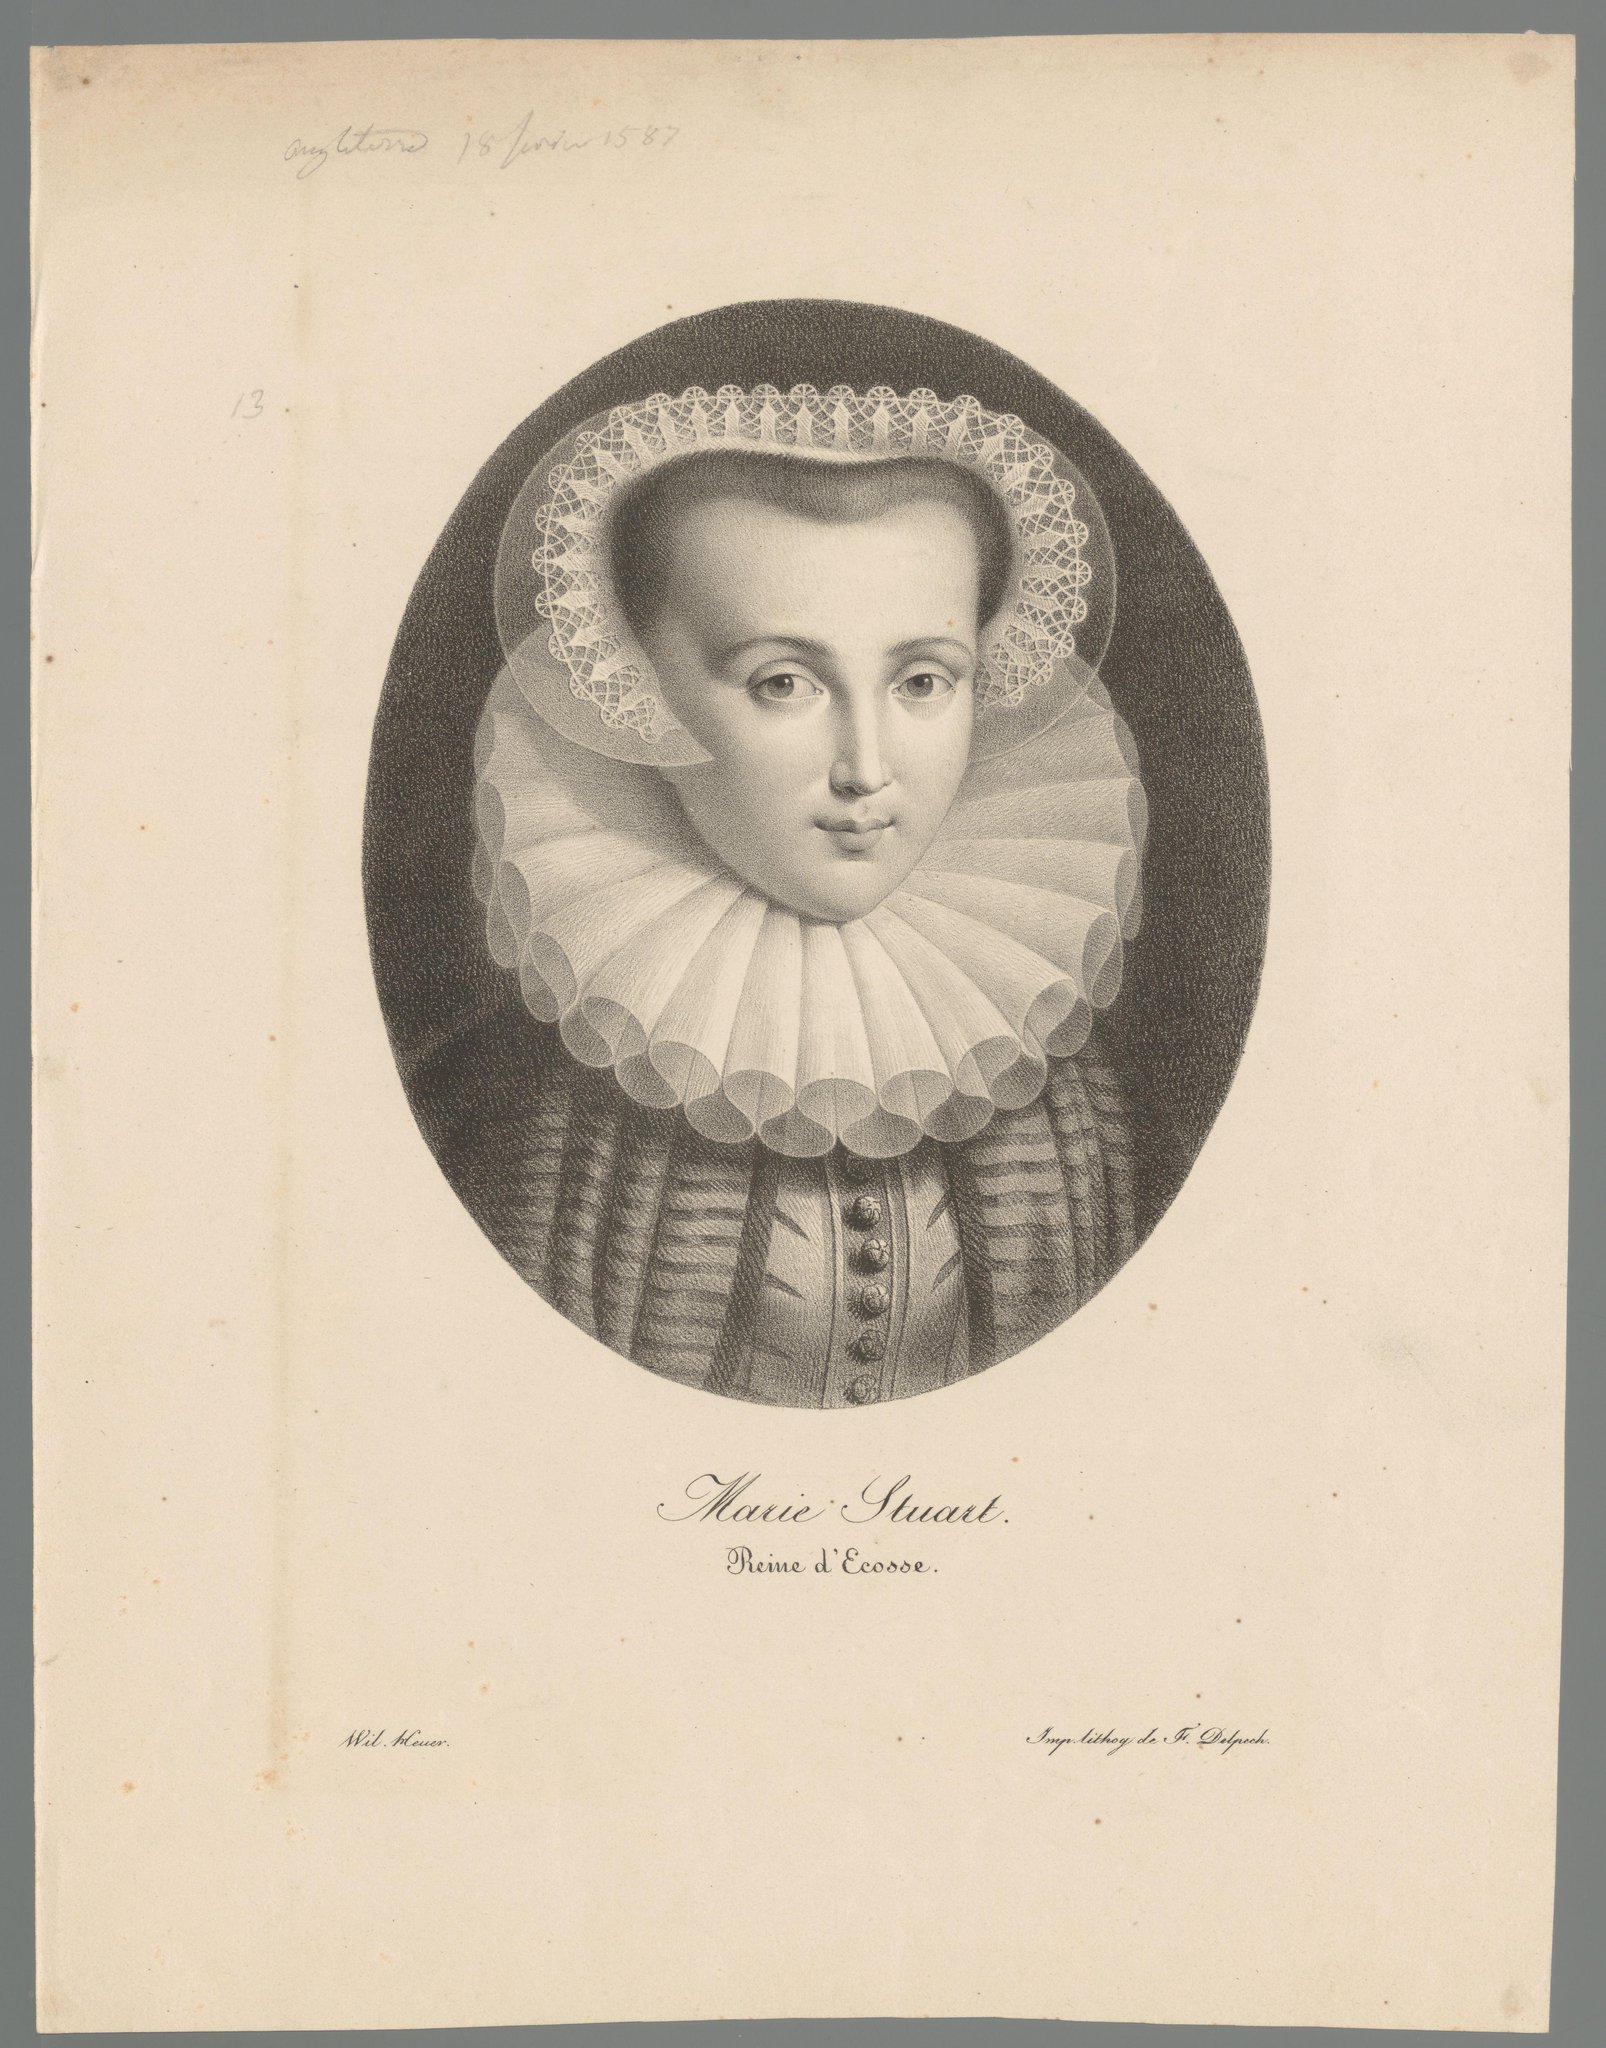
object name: print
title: Marie Stuart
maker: wilhelm heuer (1813-1890)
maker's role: print maker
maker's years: 1813-1890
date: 1823-1890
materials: paper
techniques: lithograph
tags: historical persons, queen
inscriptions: collector's mark: Lugt 2228